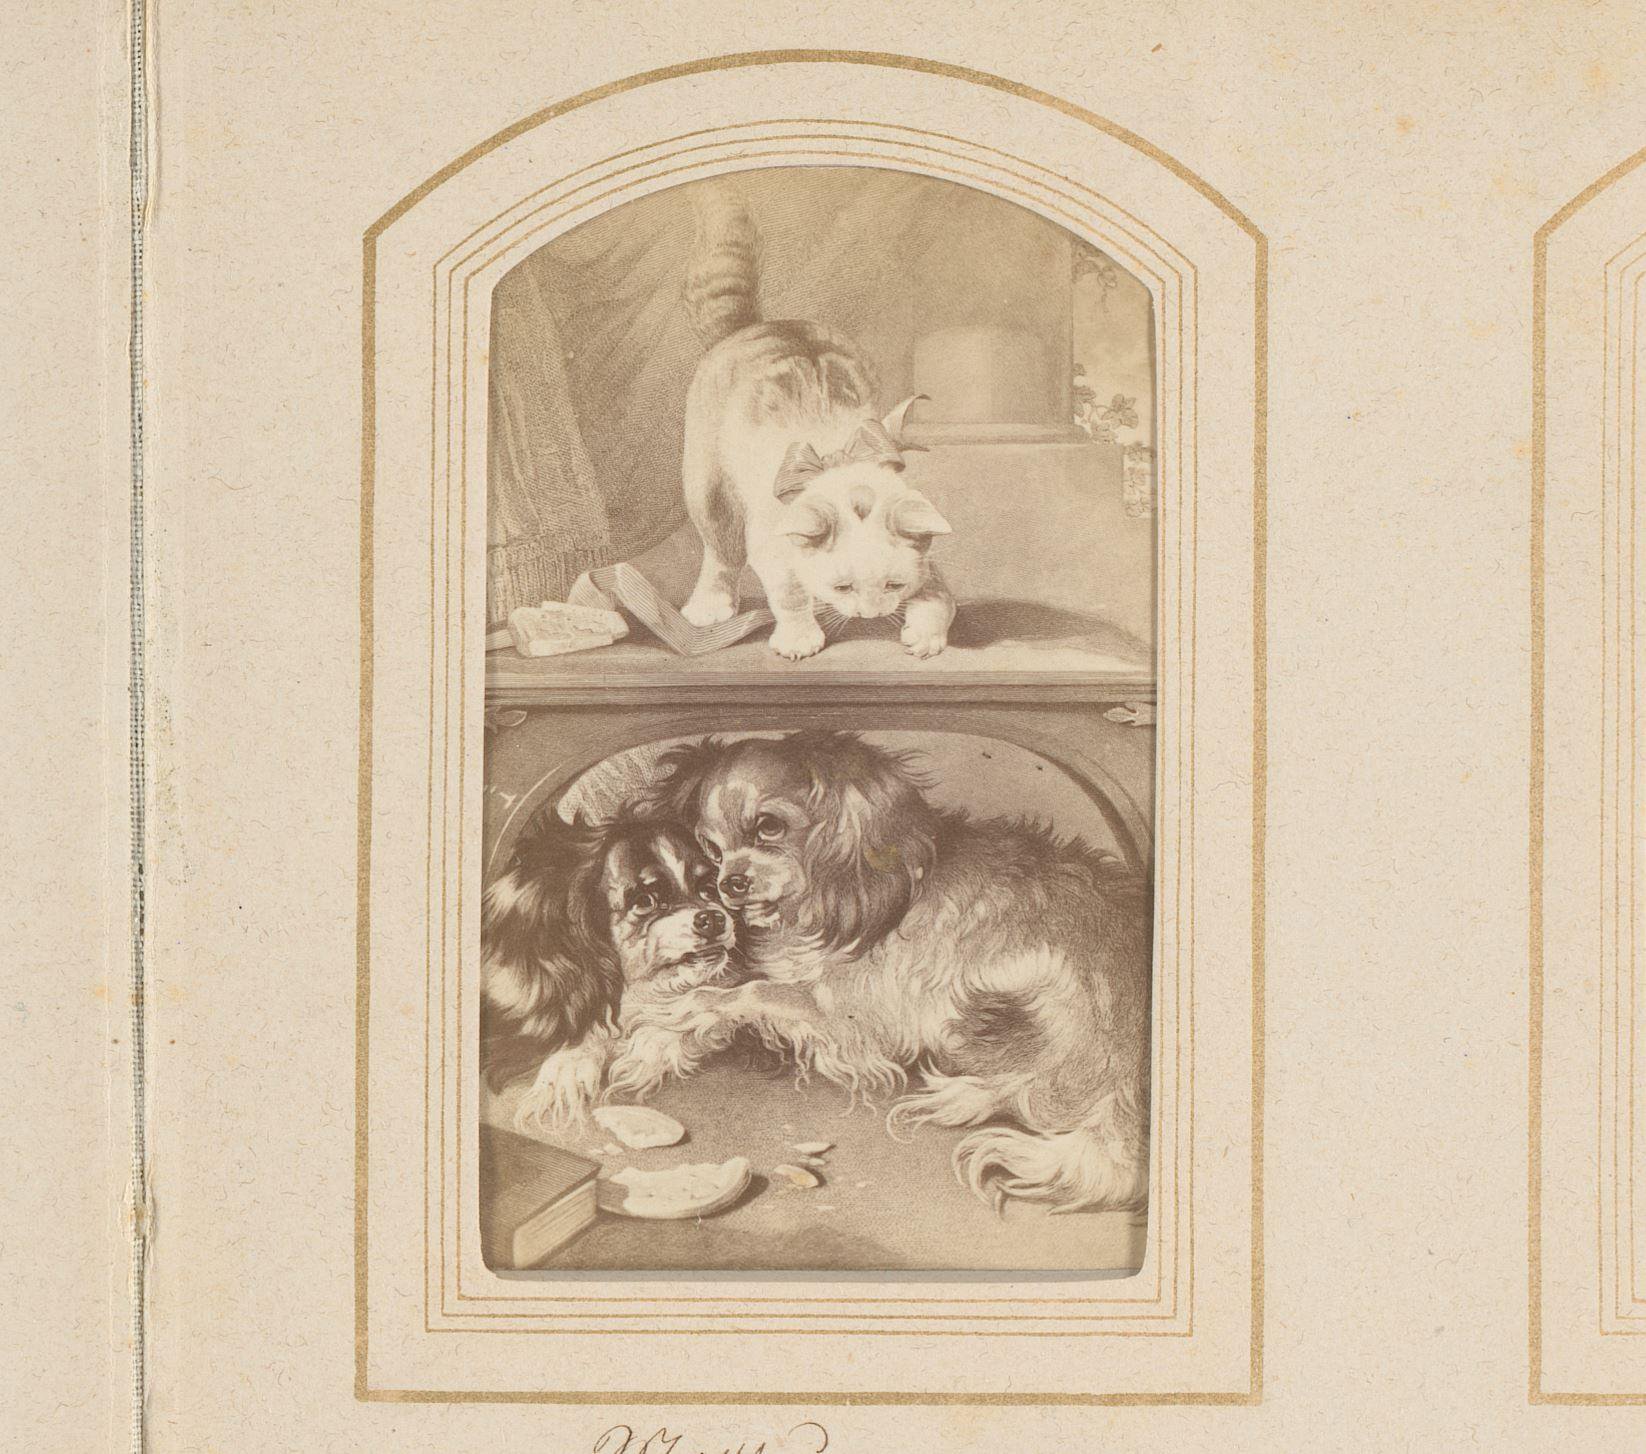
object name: reproduction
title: Fotoreproductie van Misstrauen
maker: Anonymous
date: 1870-1890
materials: cardboard, photographic support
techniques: albumen print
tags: cat, dog, painting, drawing and the graphic arts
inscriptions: number: ‘2039’, annotation: ‘Misstrauen’